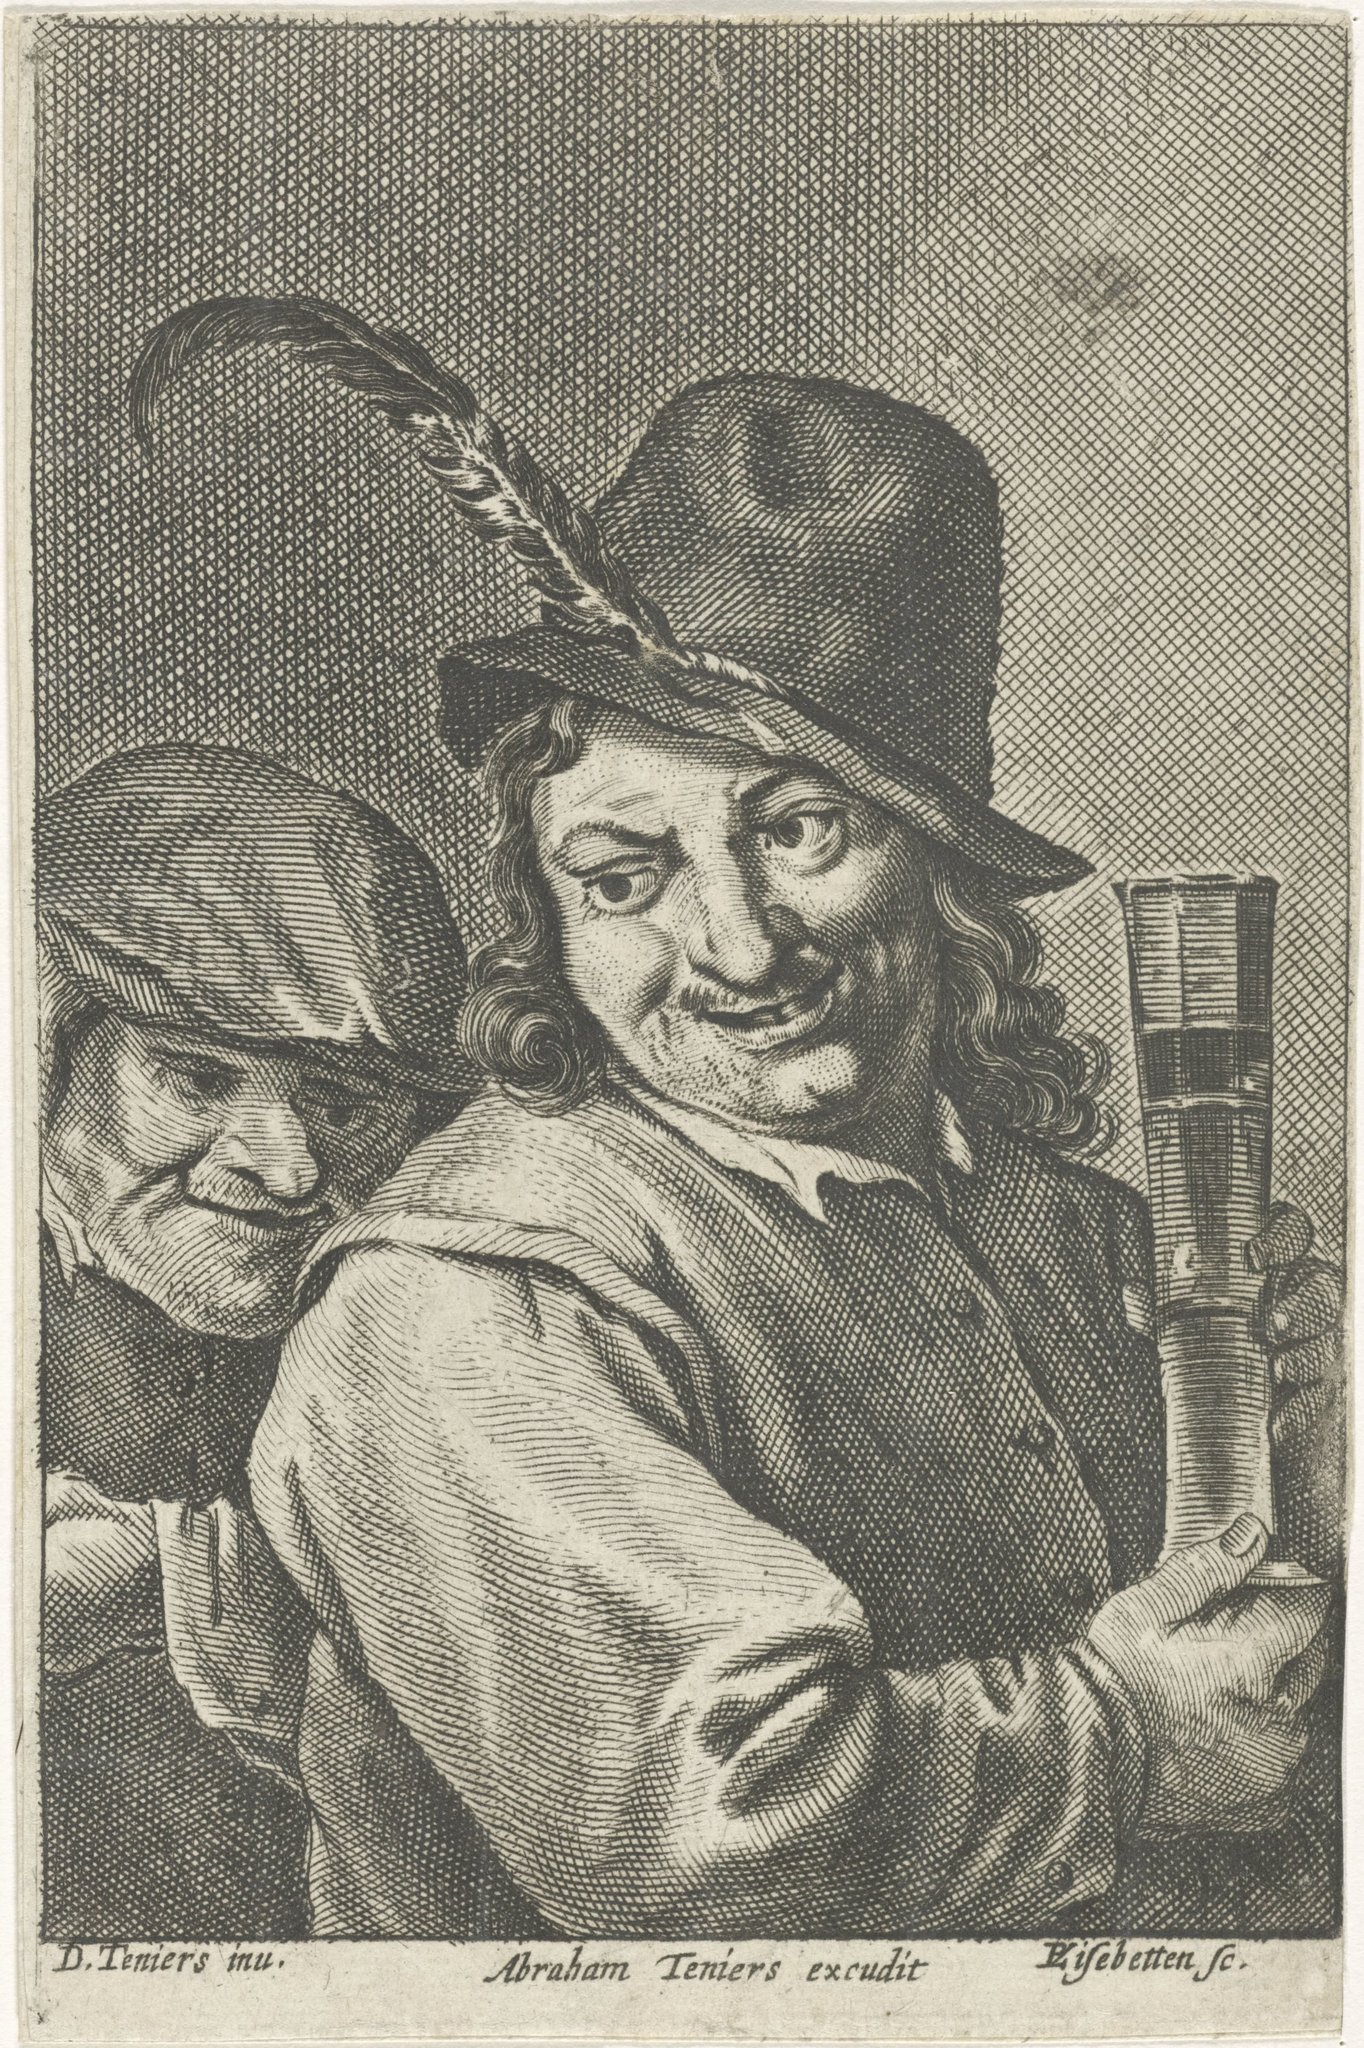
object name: print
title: Twee mannen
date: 1646-1670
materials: paper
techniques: engraving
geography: antwerp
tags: drinking, various human types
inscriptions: collector's mark: Lugt 240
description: Twee mannen, beiden met hoed. De man rechts heeft een drinkglas in zijn handen.